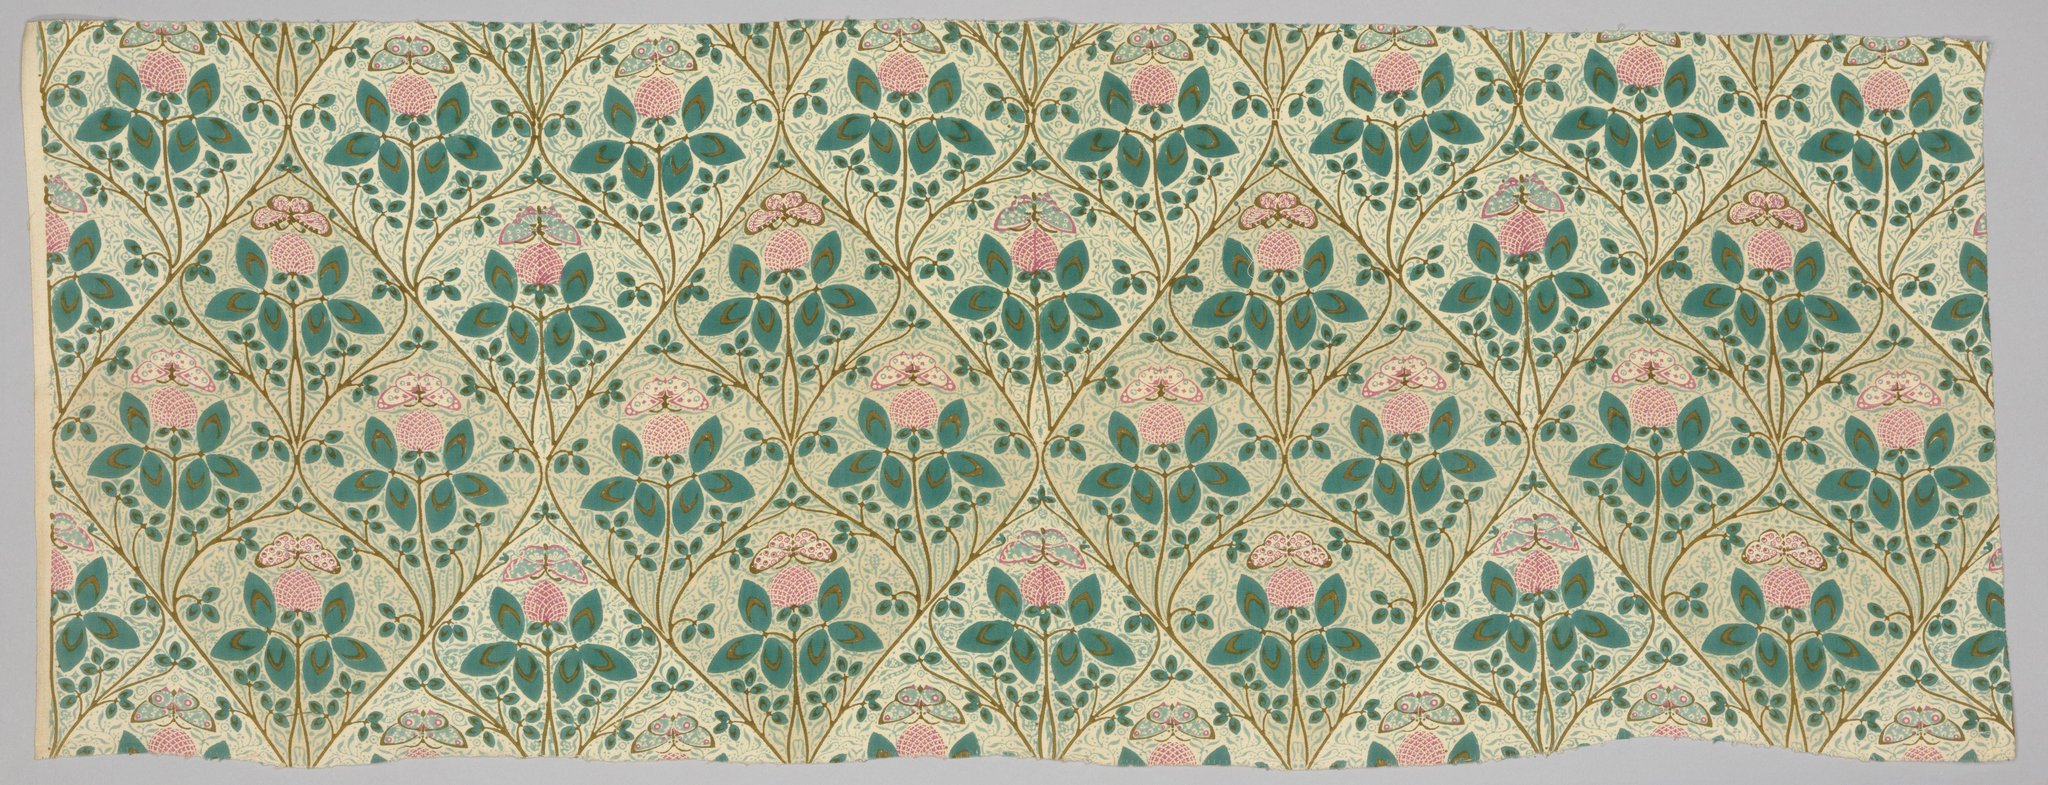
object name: upholstery fabric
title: Fragment bedrukte cretonne met patroon van klaver met vlinder binnen spitsovalen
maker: theo nieuwenhuis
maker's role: designer, draughtsman, print maker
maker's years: 1866-1951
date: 1900-1925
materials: linen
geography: helmond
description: Fragment bedrukte cretonne met patroon van klaver met vlinder binnen spitsovalen in de kleuren blauwgroen, lila en lichtblauw op naturel fond.